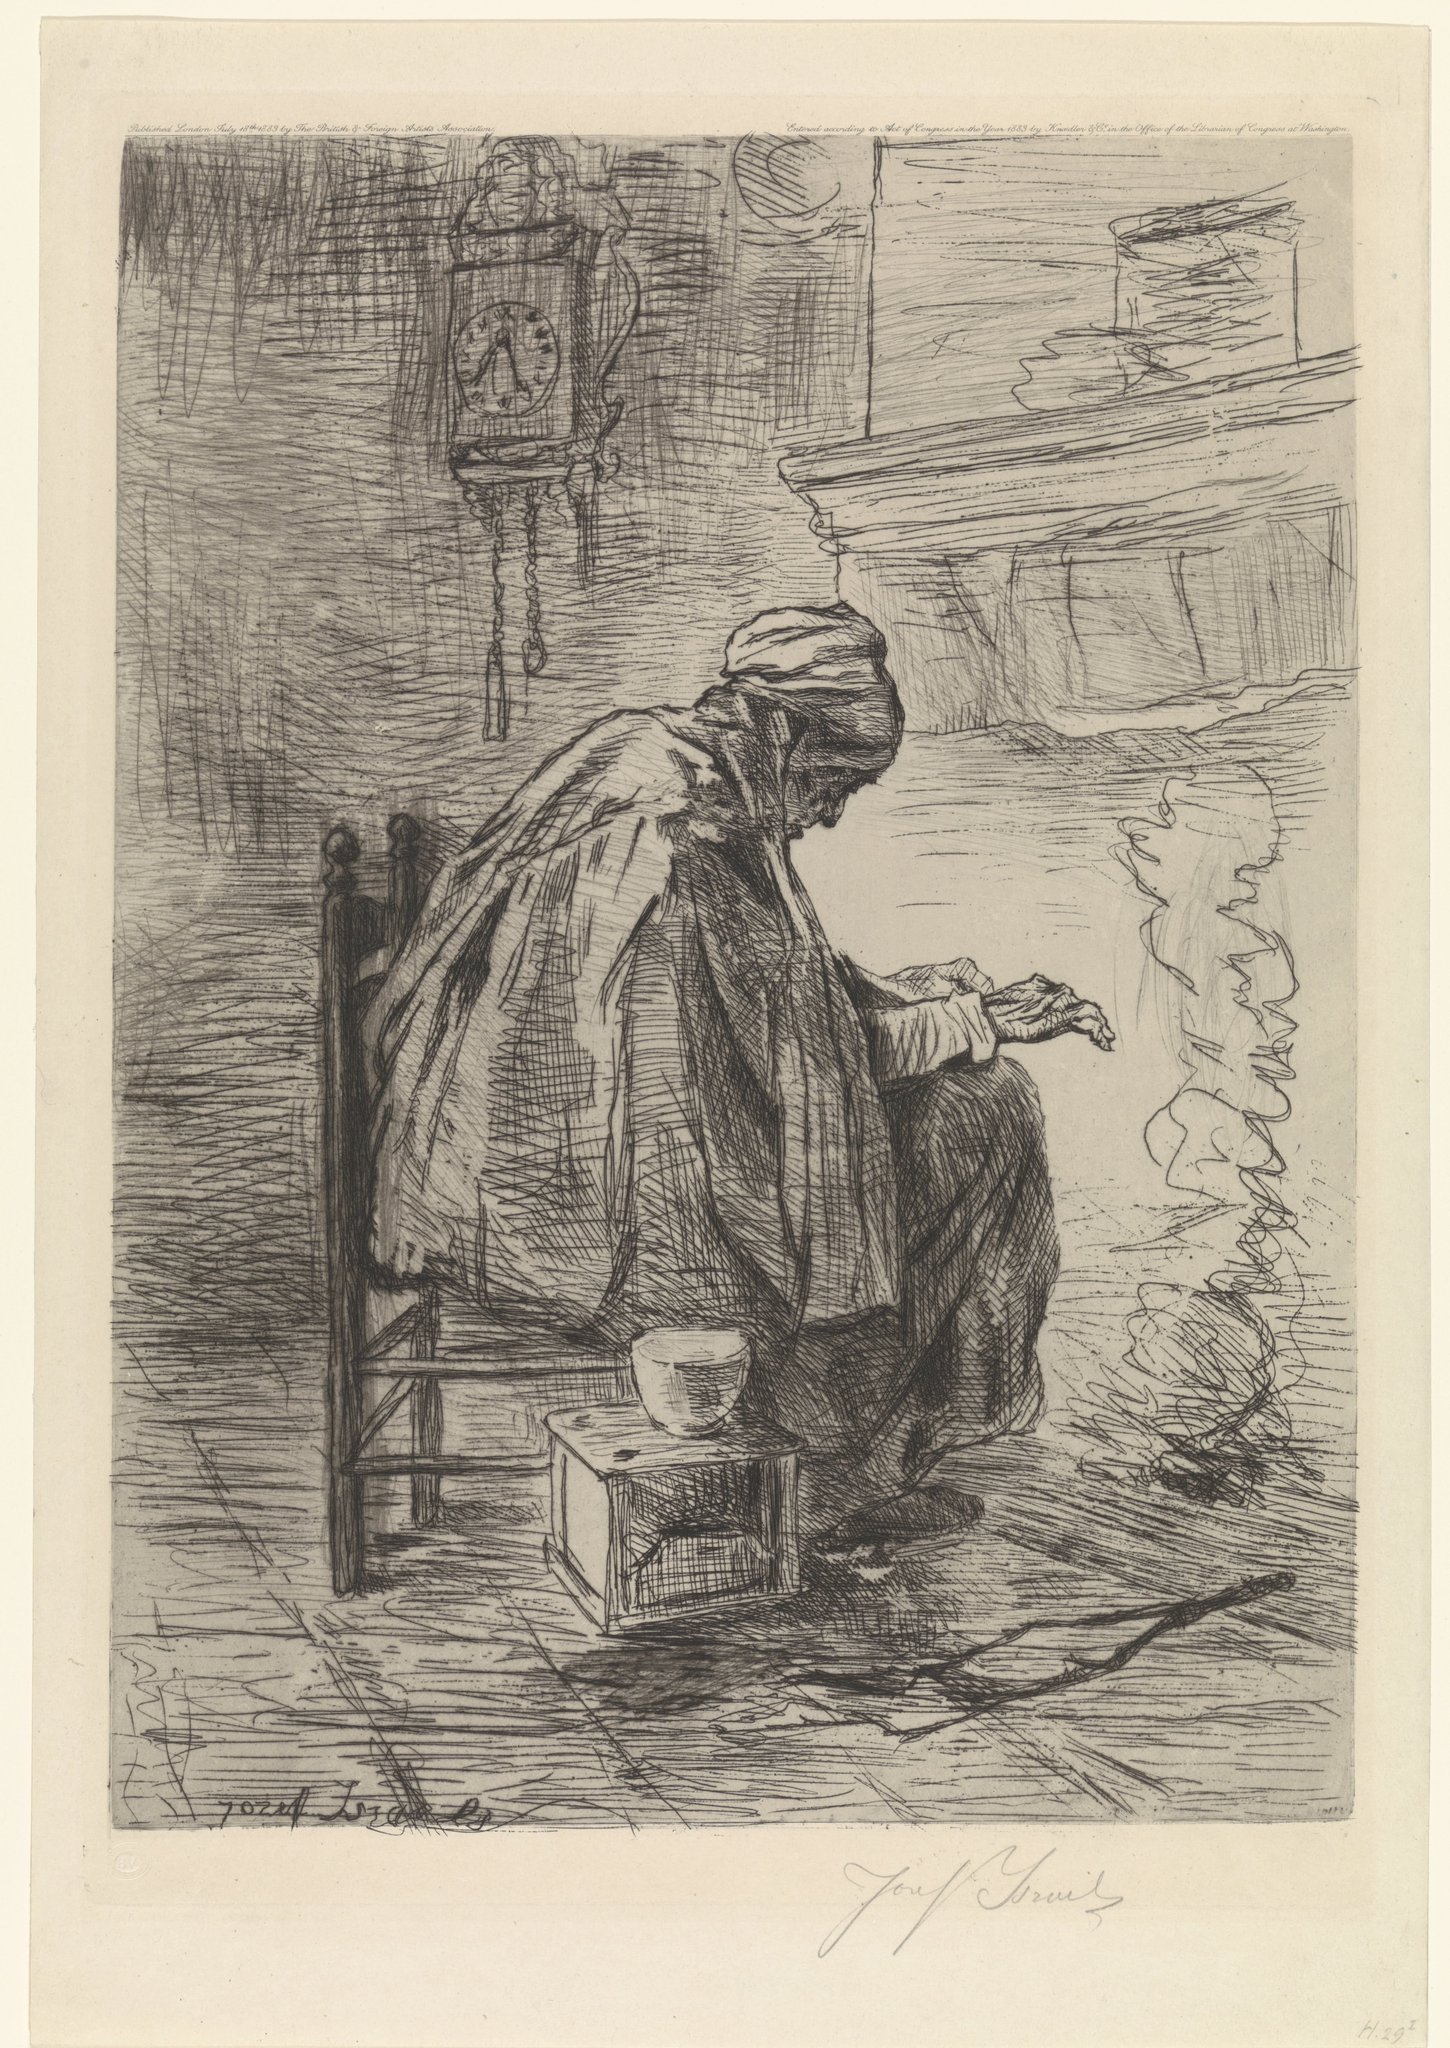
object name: print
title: Oude vrouw bij haard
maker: jozef israëls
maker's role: draughtsman, painter, print maker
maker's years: 1824-1911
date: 1883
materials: paper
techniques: etching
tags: open fire, fire-place, stove (in kitchen)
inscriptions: signature: ‘Jozef Israels’, check stamp: ‘Publishers Association BV’, collector's mark: Lugt 2228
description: Oude vrouw, zittend op stoel, haar handen warmend aan de haard. Rechts naast haar een krukje met kom erop. Links aan de muur hangt een wandklok.